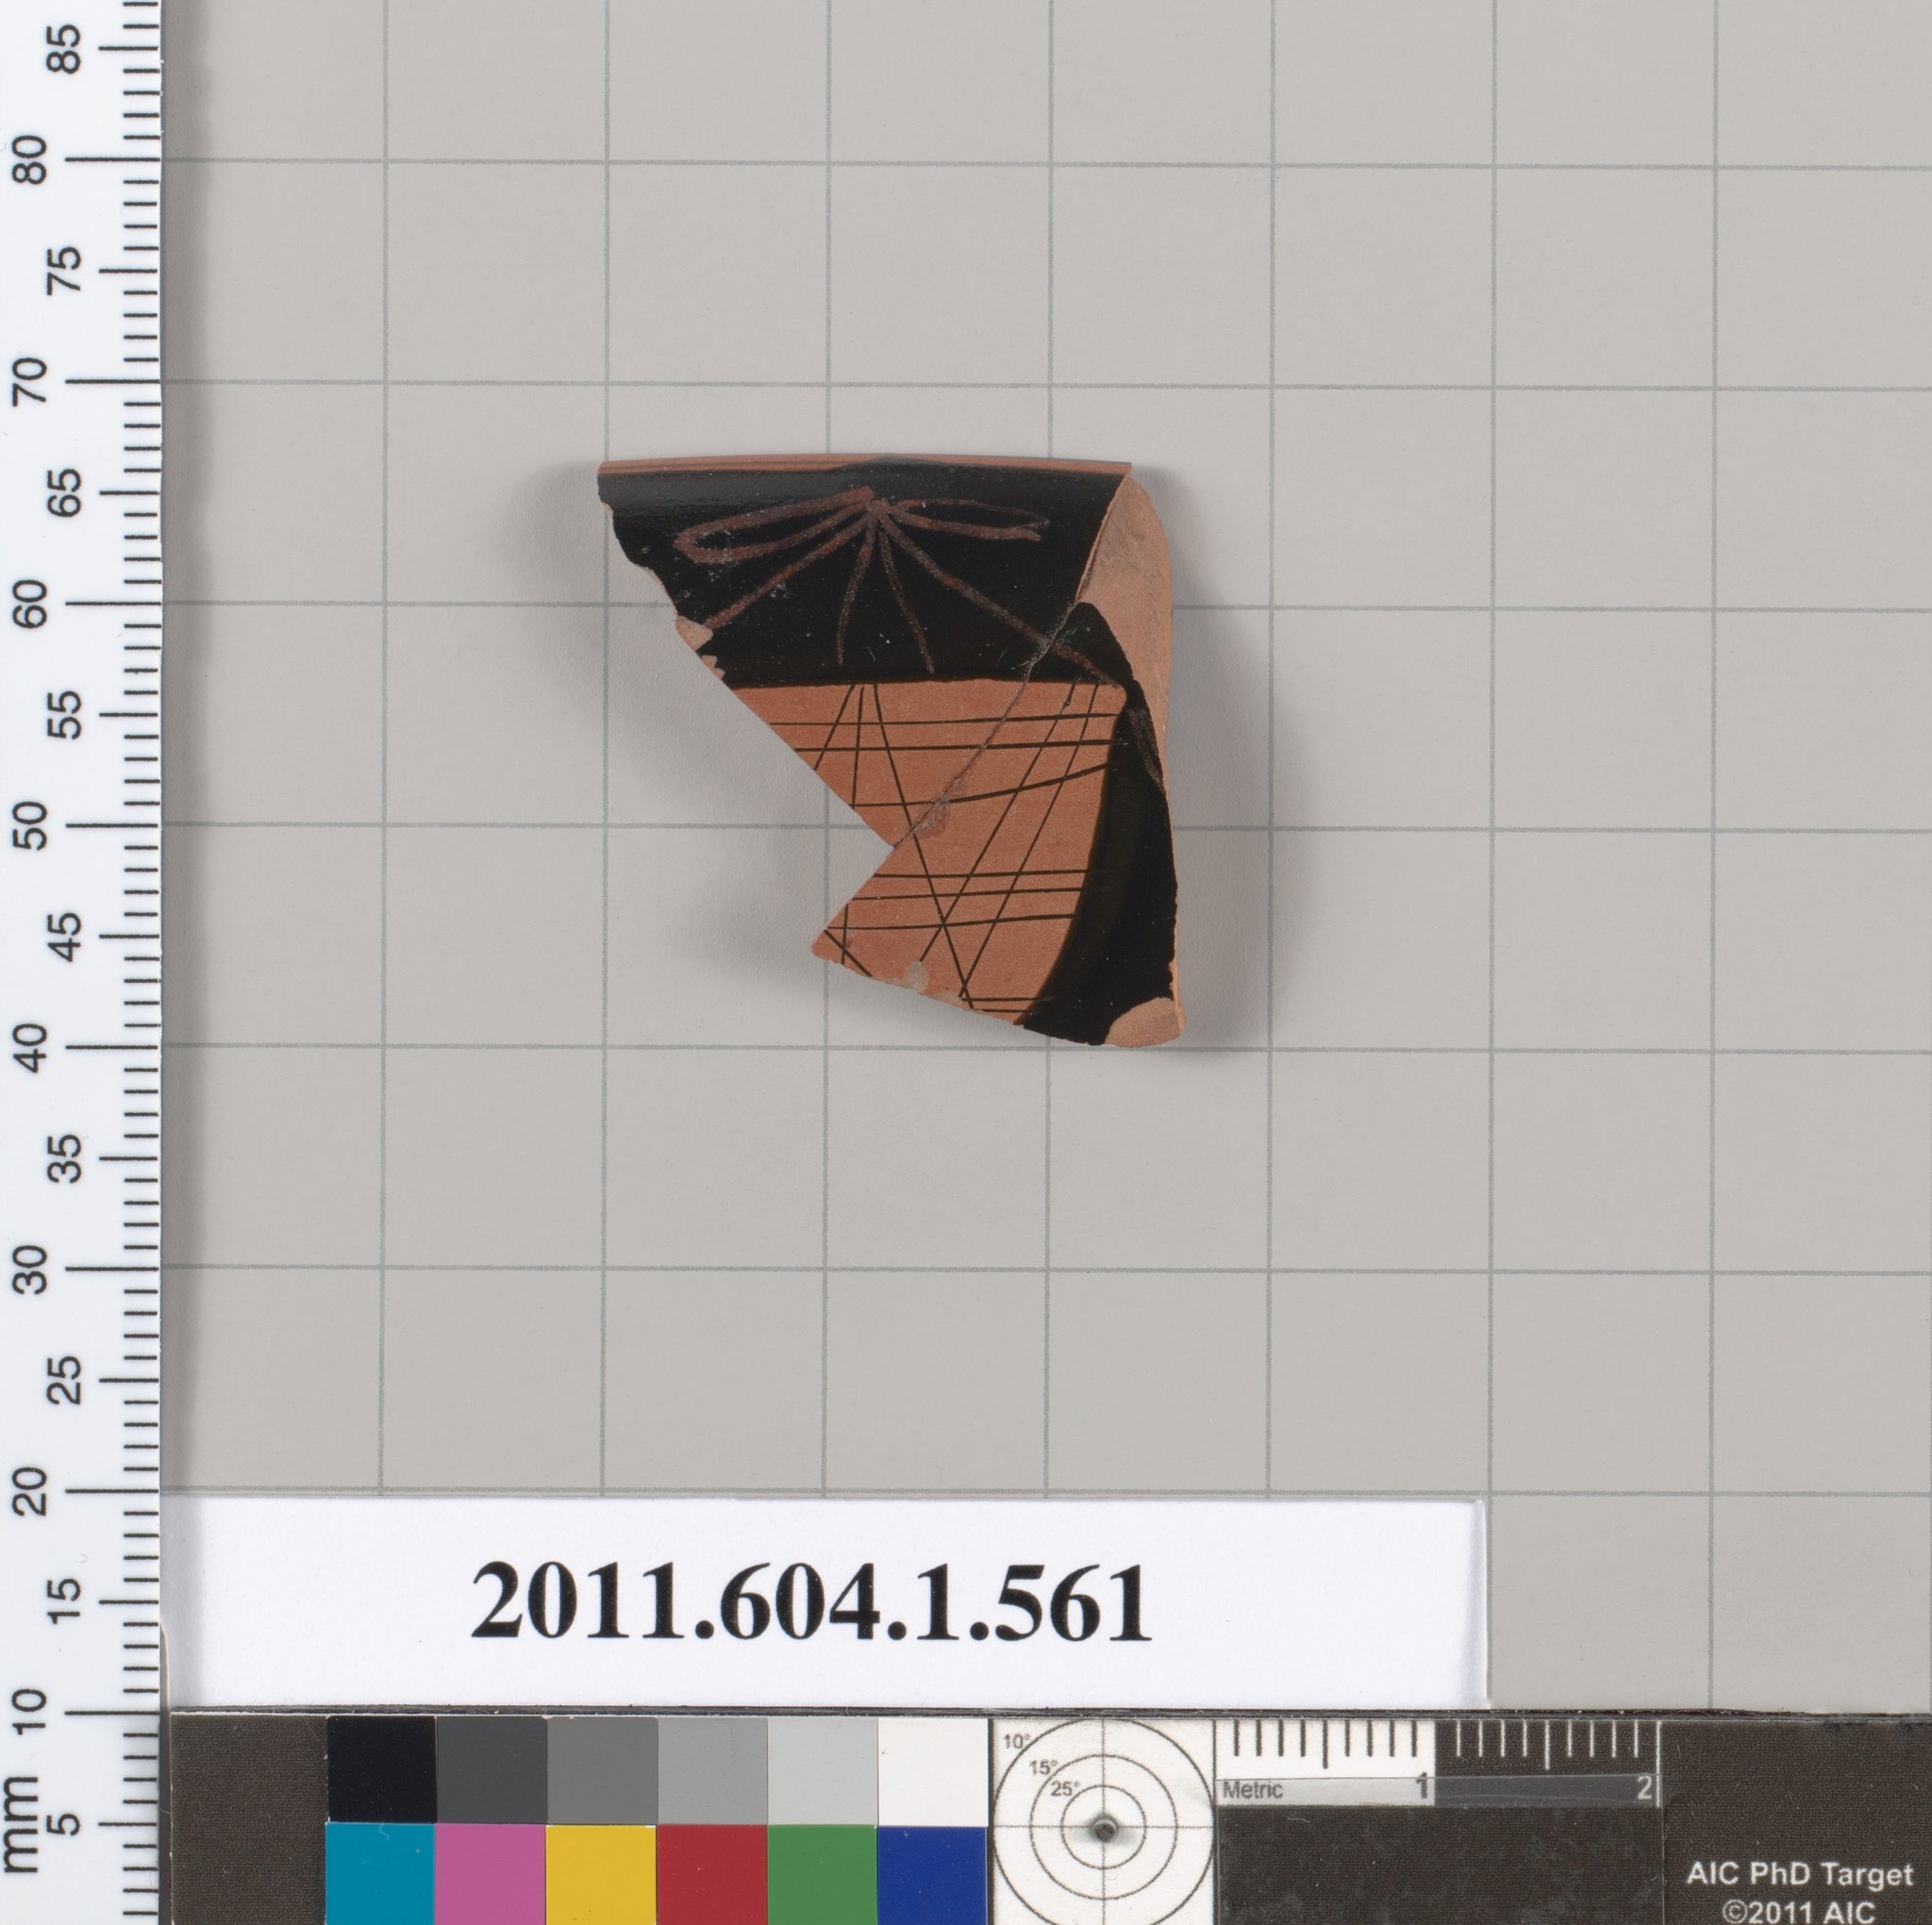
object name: kylix fragment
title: Terracotta rim fragment of a kylix (drinking cup)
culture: greek, attic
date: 480-470 BCE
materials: terracotta